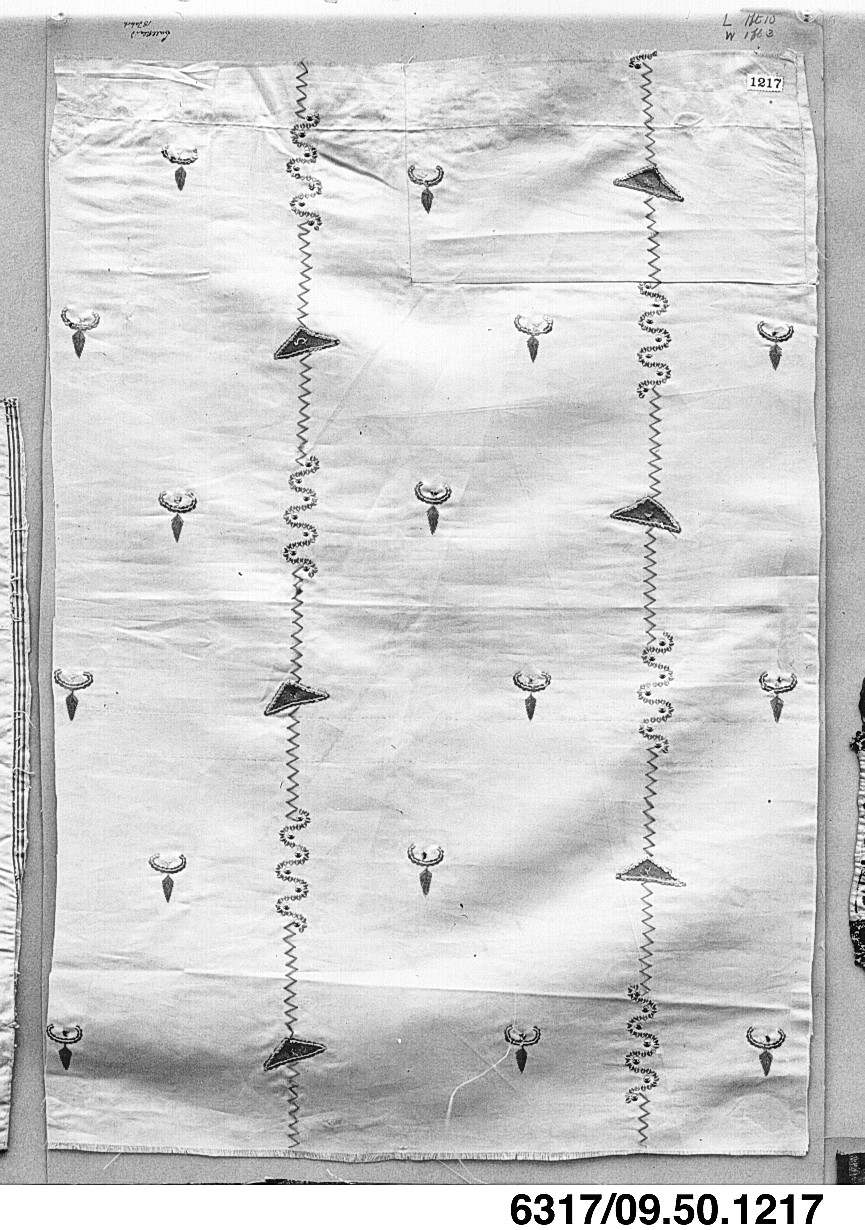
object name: fragment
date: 1767-1800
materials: gold, silk